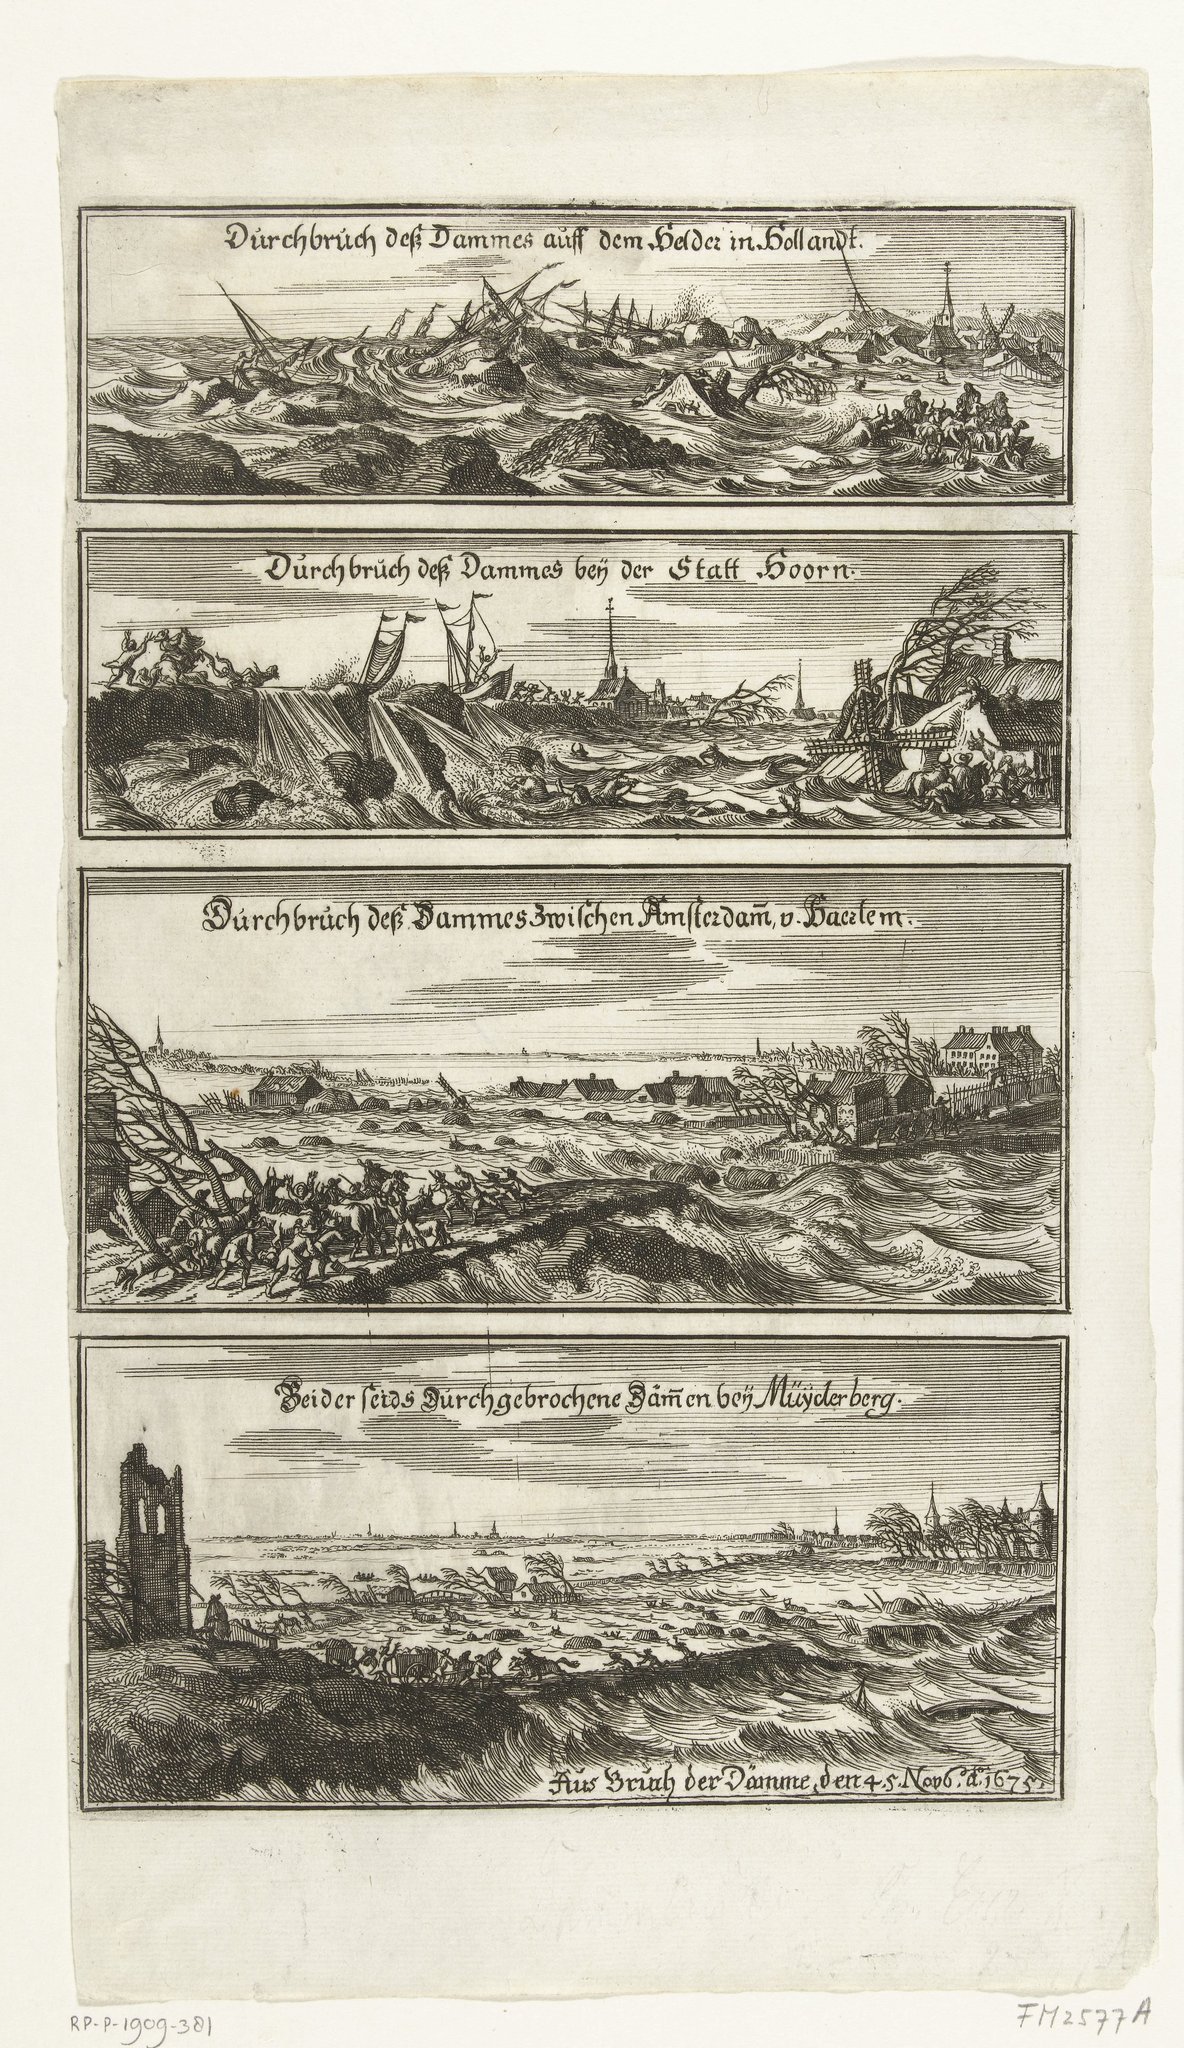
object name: print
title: Aus Bruch der Dämme, den 4.5. Novb. ao. 1675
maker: Anonymous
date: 1675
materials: paper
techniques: engraving, etching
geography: germany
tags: dike-break, den helder, hoorn (north holland)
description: Dijkdoorbraken tijdens de Allerheiligenvloed van 4-5 november 1675. Vier afzonderlijke voorstellingen onder elkaar van de overstromingen wegens doorgebroken dijken te Den Helder, Hoorn, tussen Amsterdam en Haarlem en bij Muiderberg. Met opschriften in het Duits.